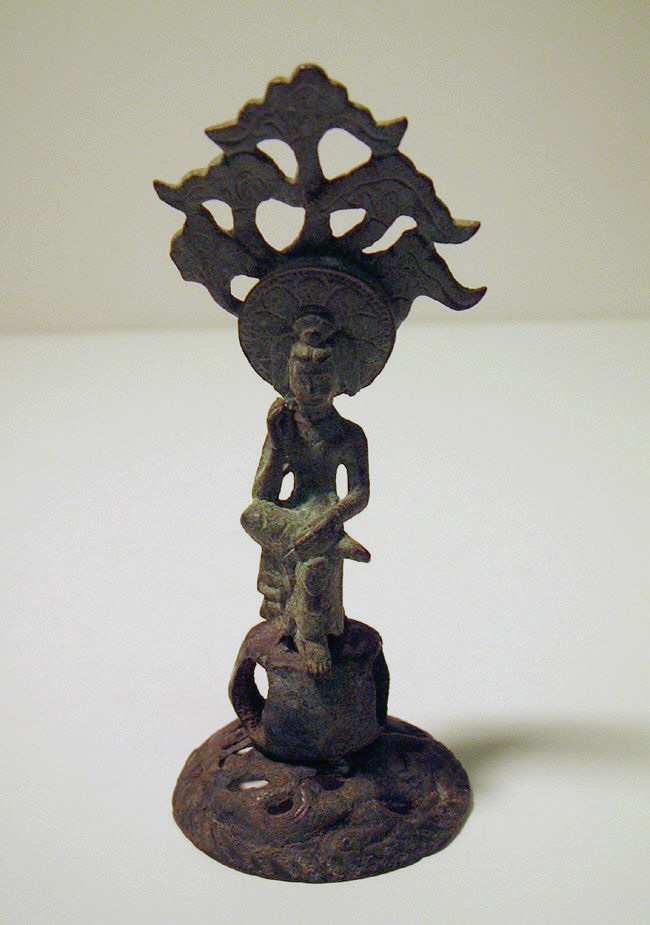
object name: figurine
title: Seated bodhisattva in pensive pose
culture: chinese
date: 581-618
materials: bronze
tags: buddhism,bodhisattvas